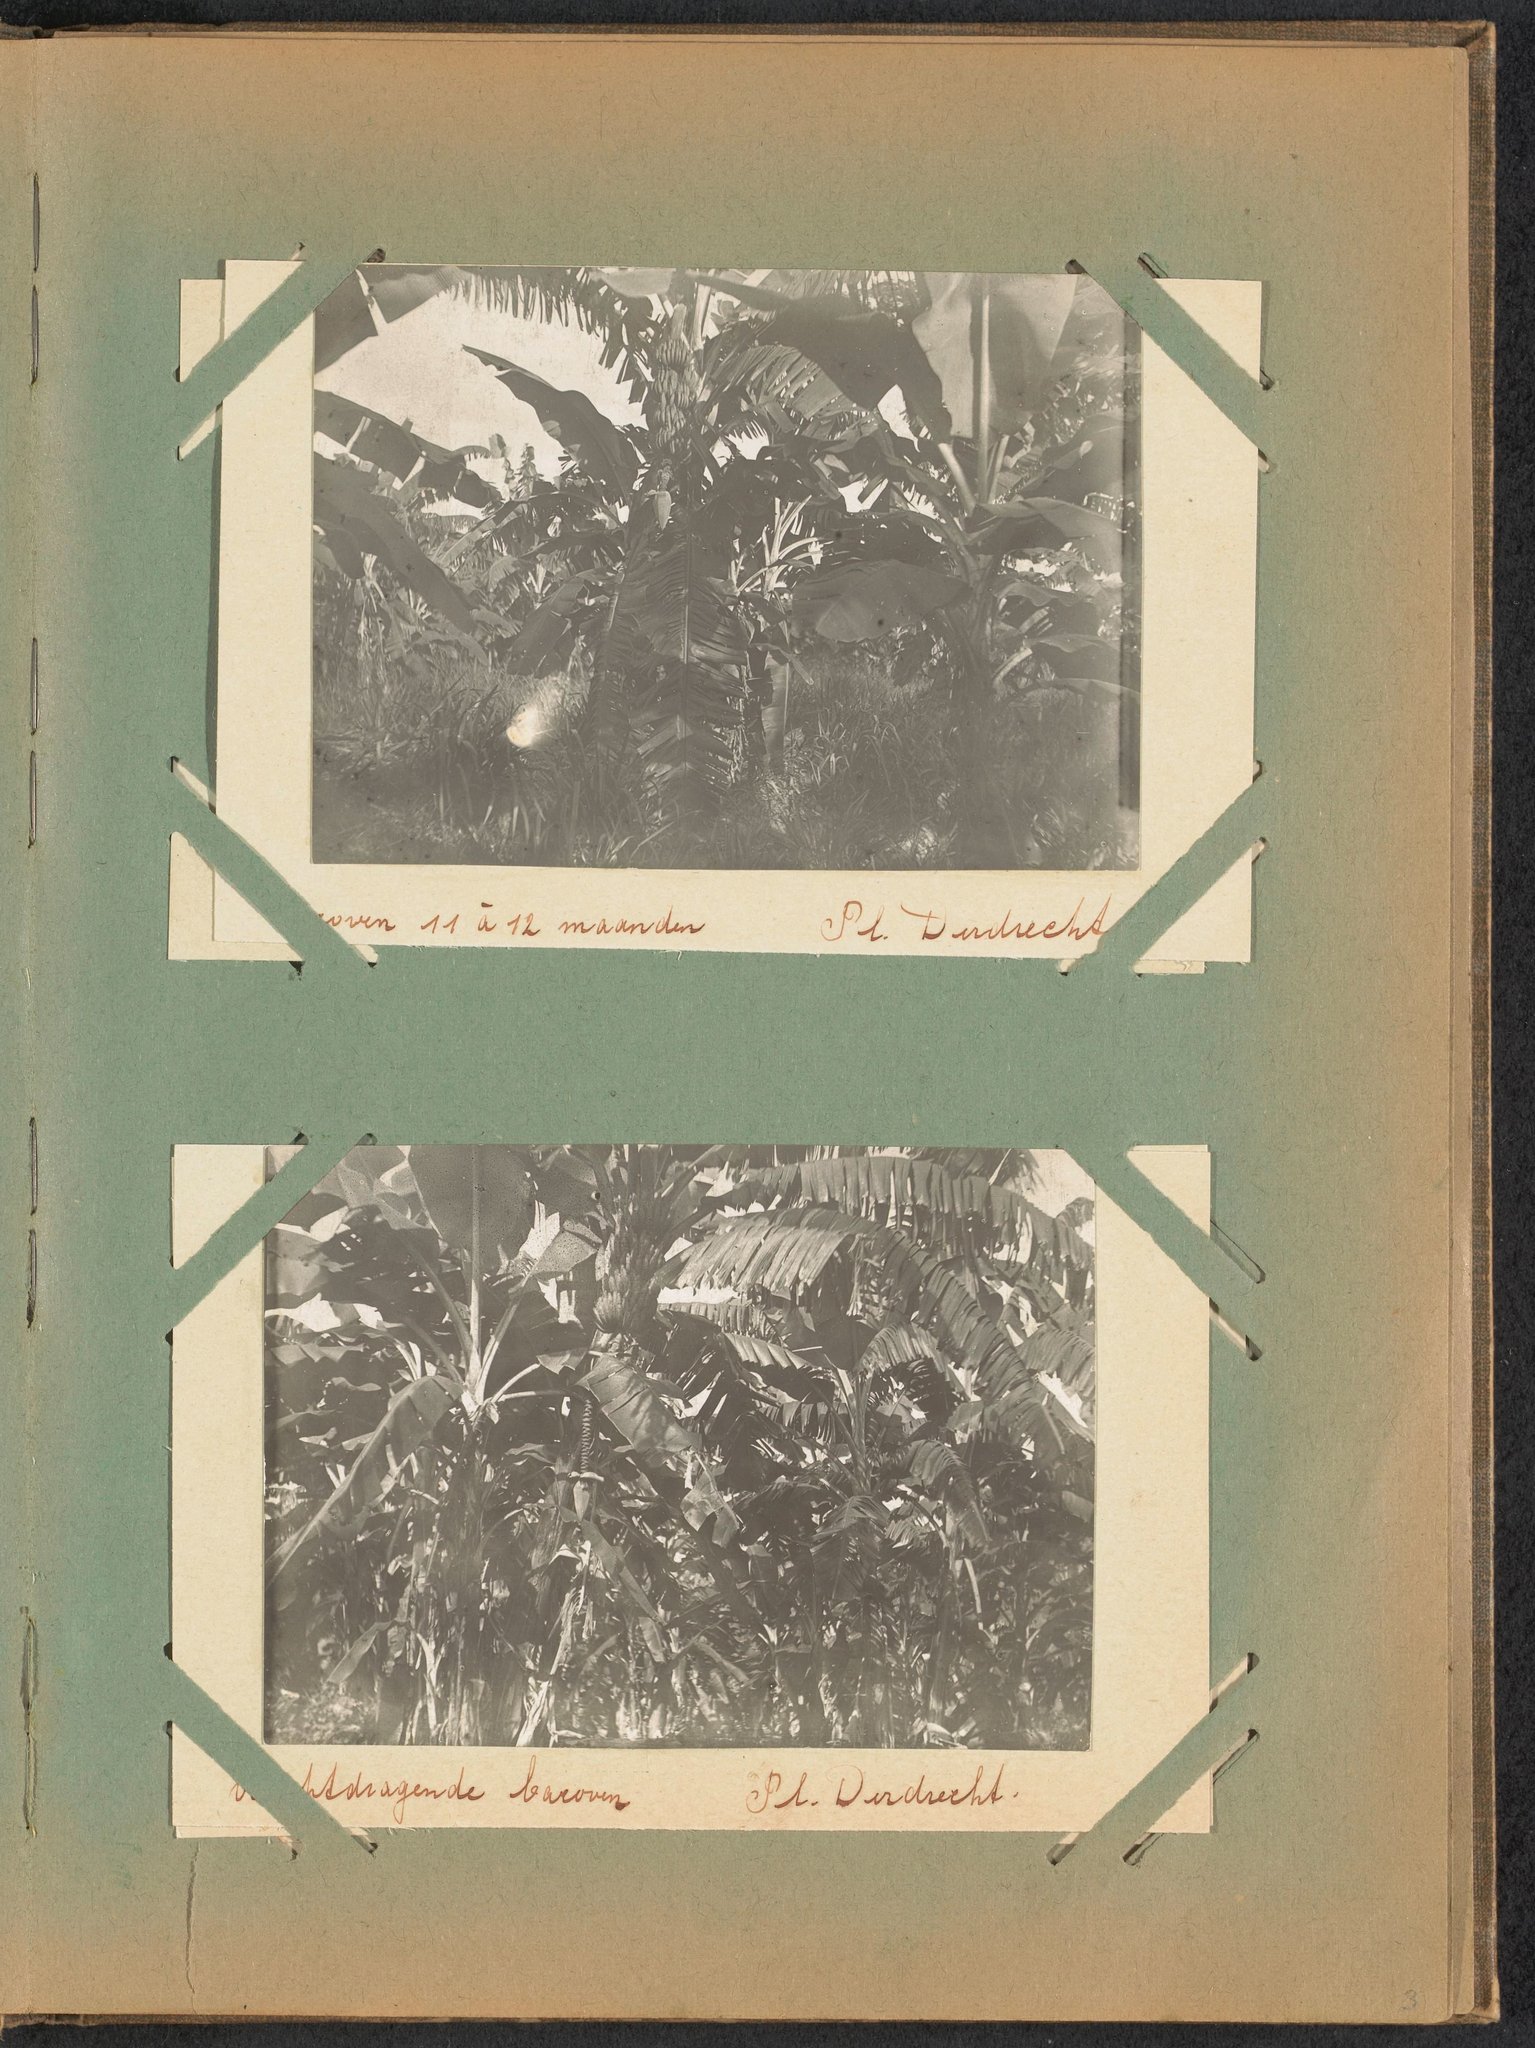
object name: photograph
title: Bananenbomen op Plantage Dordrecht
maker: Anonymous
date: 1912-1913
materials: paper, photographic support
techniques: gelatin silver print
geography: suriname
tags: plantation, fruits: banana, suriname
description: Bananenbomen op Plantage Dordrecht in Suriname. Onderdeel van het fotoalbum uit ca. 1912-1913 met 92 foto's van de plantages Peperpot en Dordrecht in Suriname en Mount Pleasant op Curaçao.